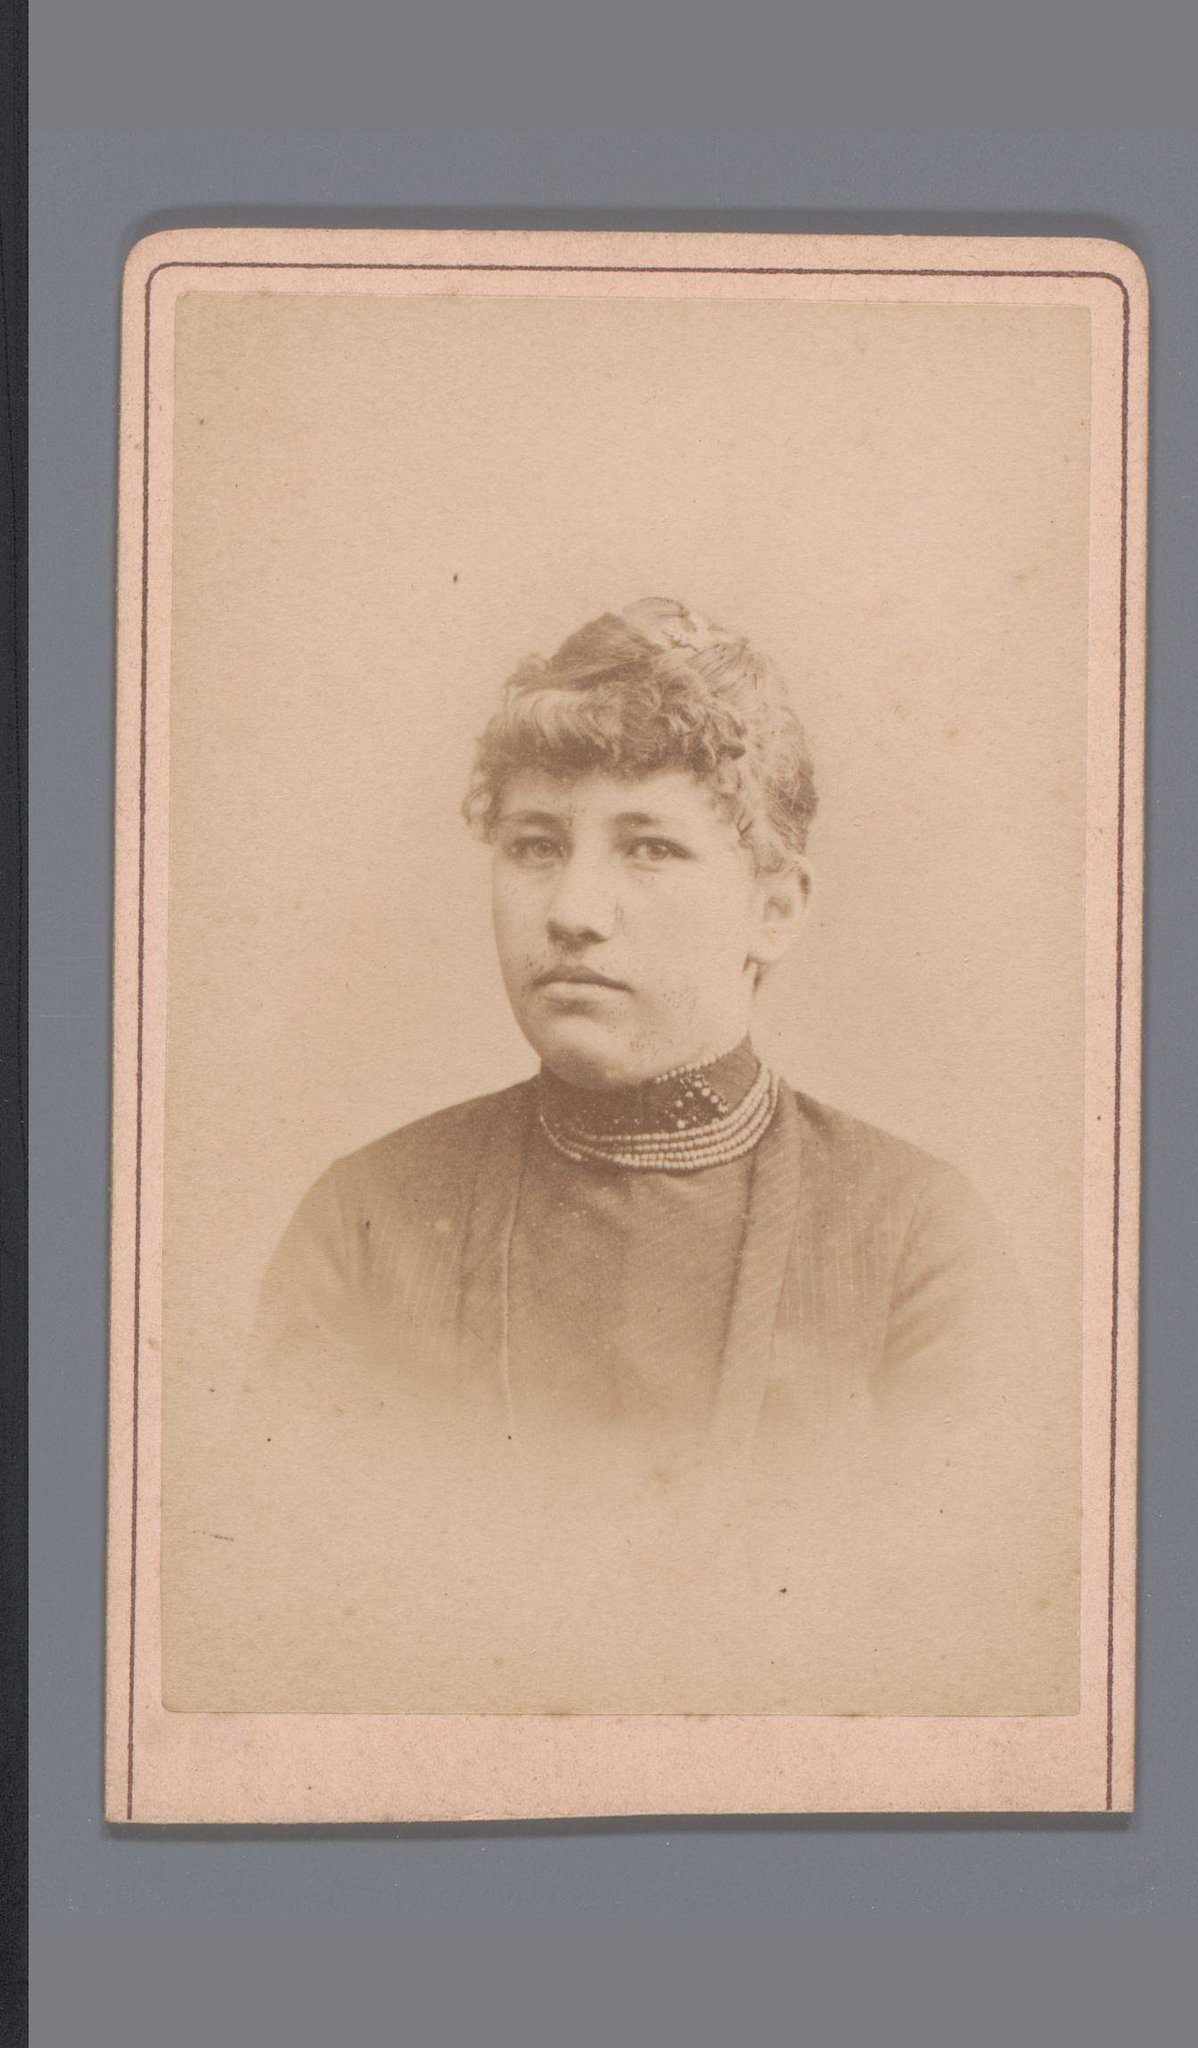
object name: photograph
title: Portret van een onbekende vrouw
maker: friedrich julius von kolkow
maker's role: fotograaf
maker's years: 1839-1914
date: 1884-1896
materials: cardboard, paper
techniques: albumen print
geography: groningen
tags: historical persons - bb - woman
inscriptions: inscription: ‘GOUDEN MEDALJE VOOR KUNST EN WETENSCHAP v Z. M. de KONING v WÜRTTEMBERG/ aan het lint der Frederiksorde/ PHILADELPHIA 1876. WIEN 1873./ FR. JUL. VON KOLKOW/ KONINKLIJK NEDERLANDSCH HOF-PHOTOGRAPH/ Silberne Voigtländer Medaille Kunst u Wissenschaft Oldenburg/ en tien zilveren Medaljes op andere Tentoonstellingen./ GRONINGEN/ Groote Markt bij de/ Martinitoorn./ Specialiteit in Vergrootingen.’